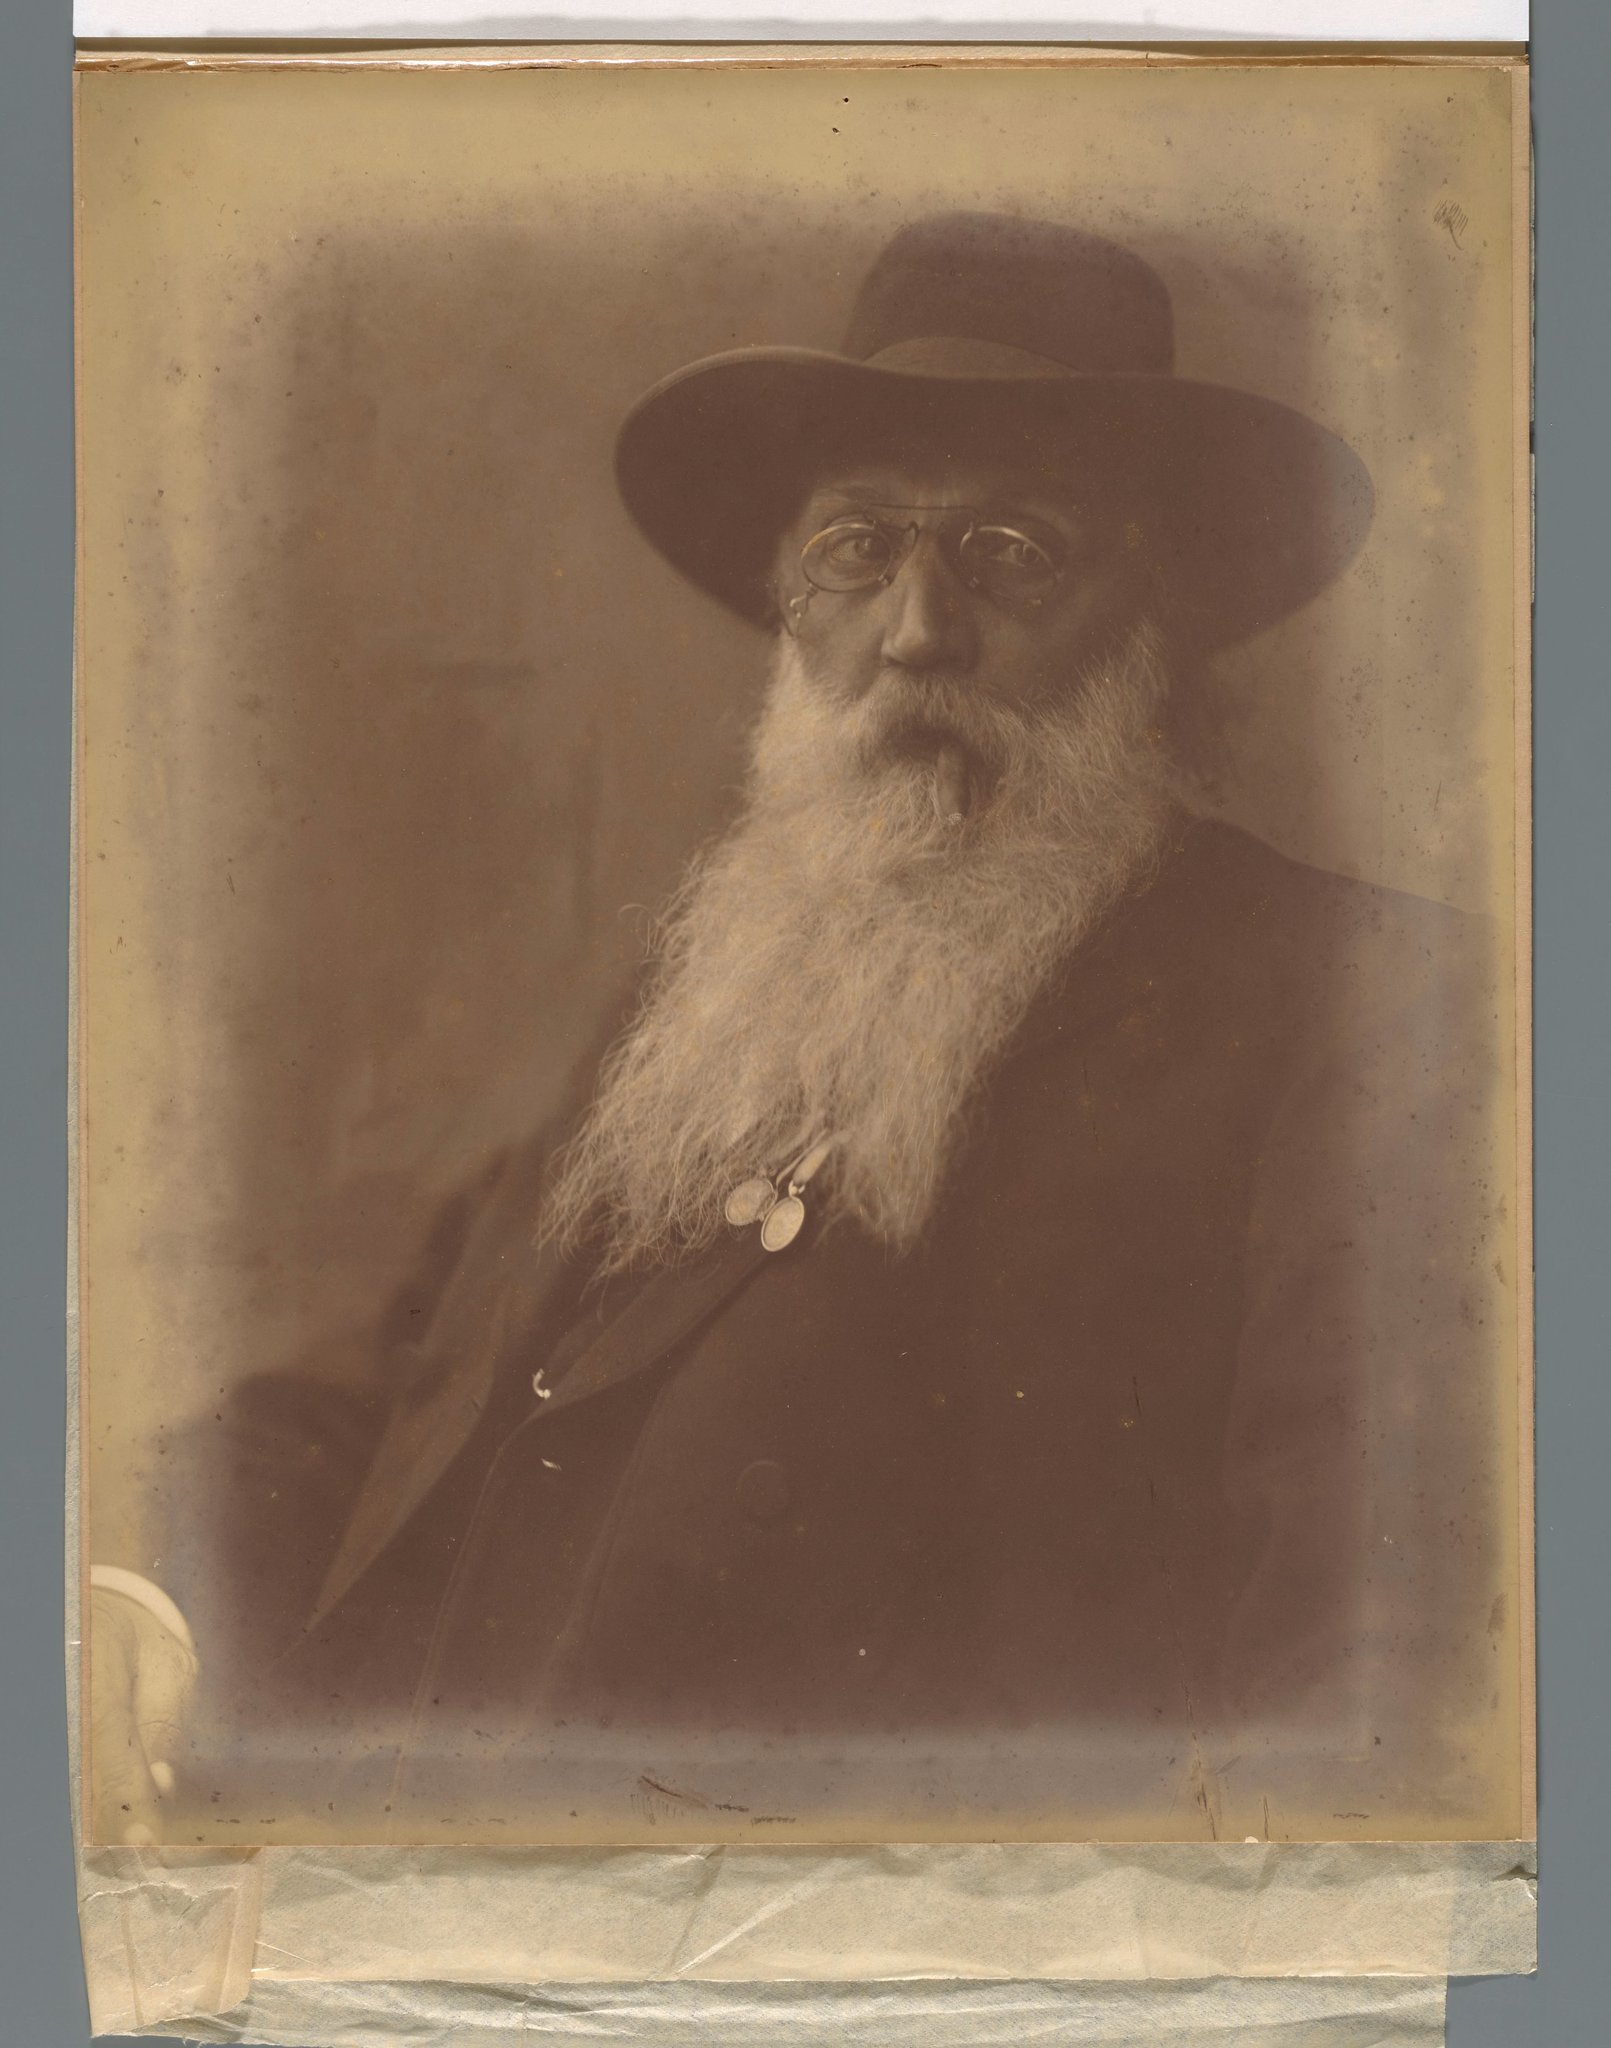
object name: photograph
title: Portret van een man met baard en hoed en een sigaar in de mond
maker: jacob merkelbach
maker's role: fotograaf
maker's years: 1877-1942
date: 1925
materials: cardboard, photographic support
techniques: gelatin silver print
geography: amsterdam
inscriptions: inscription: ‘Korrelaar, tractaatjesman’